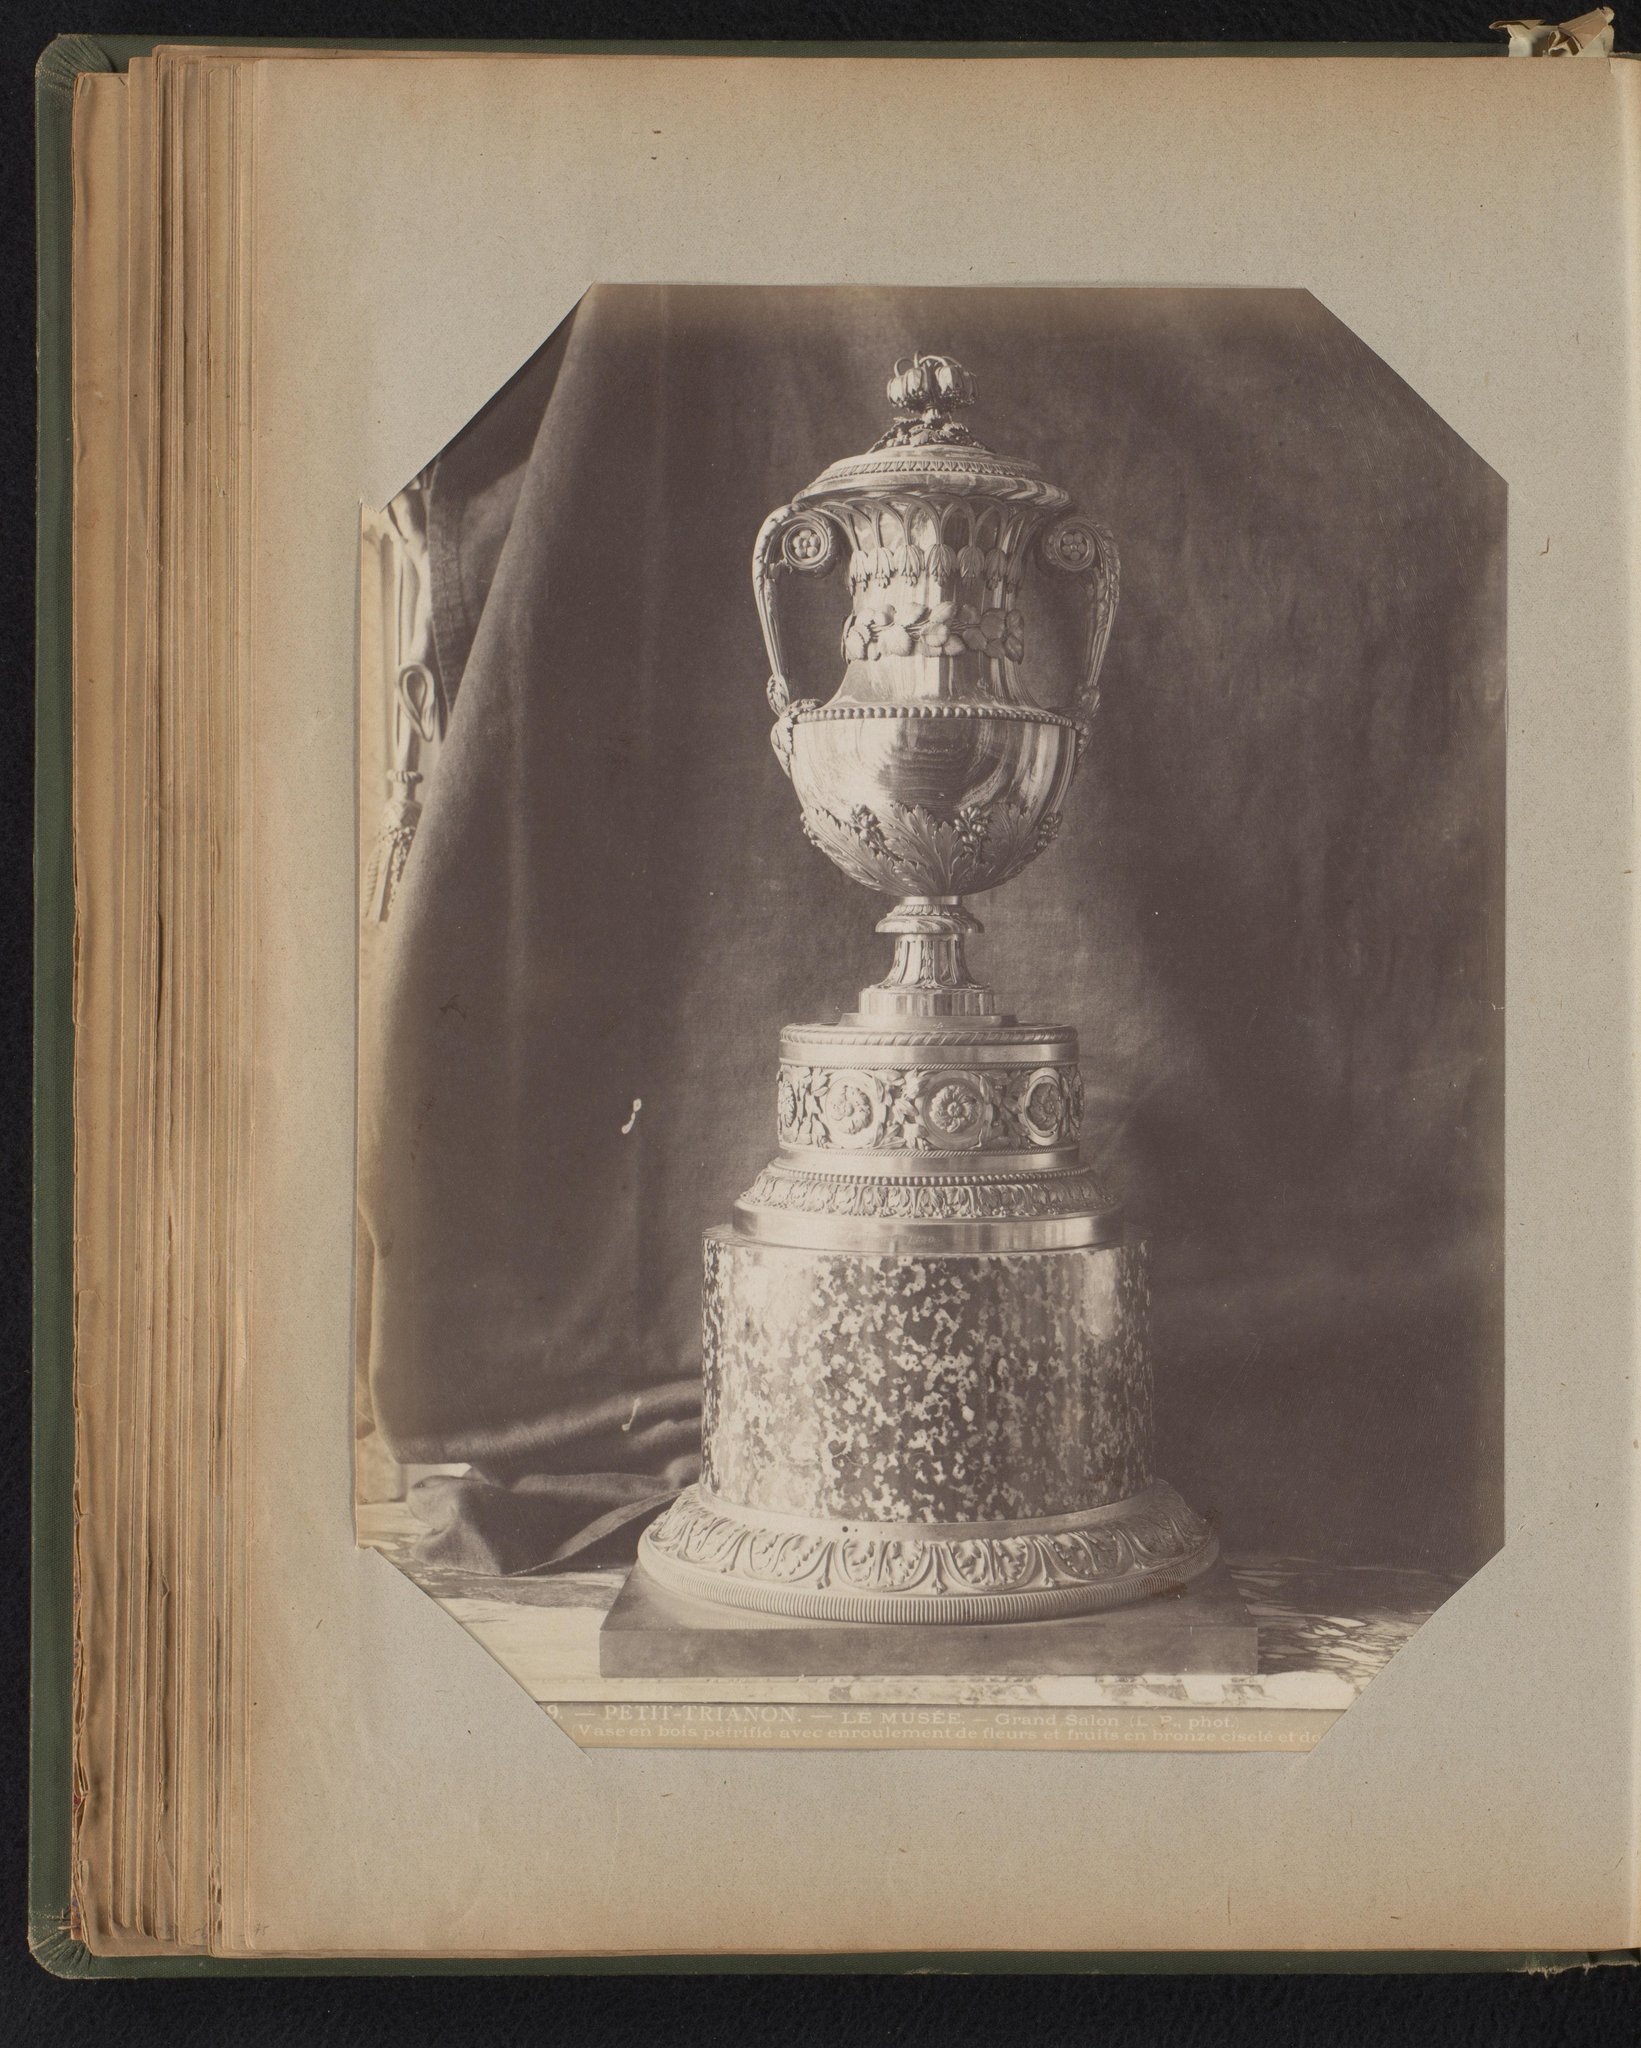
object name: photograph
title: 299. - Petit Trianon - Le Mussee - Grand Salon (L.P. Phot) (Vase en bois petrifle avec enroulement de fleurs et fruits en bronze cisele et doré.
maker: Anonymous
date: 1860-1900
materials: paper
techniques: albumen print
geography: france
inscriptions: annotation: ‘299. - Petit Trianon - Le Mussee - Grand Salon (L.P. Phot) (Vase en bois petrifle avec enroulement de fleurs et fruits en bronze cisele et doré.’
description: Op de vaas staat een voorstelling die de superioriteit van Frankrijk over Spanje beschrijft